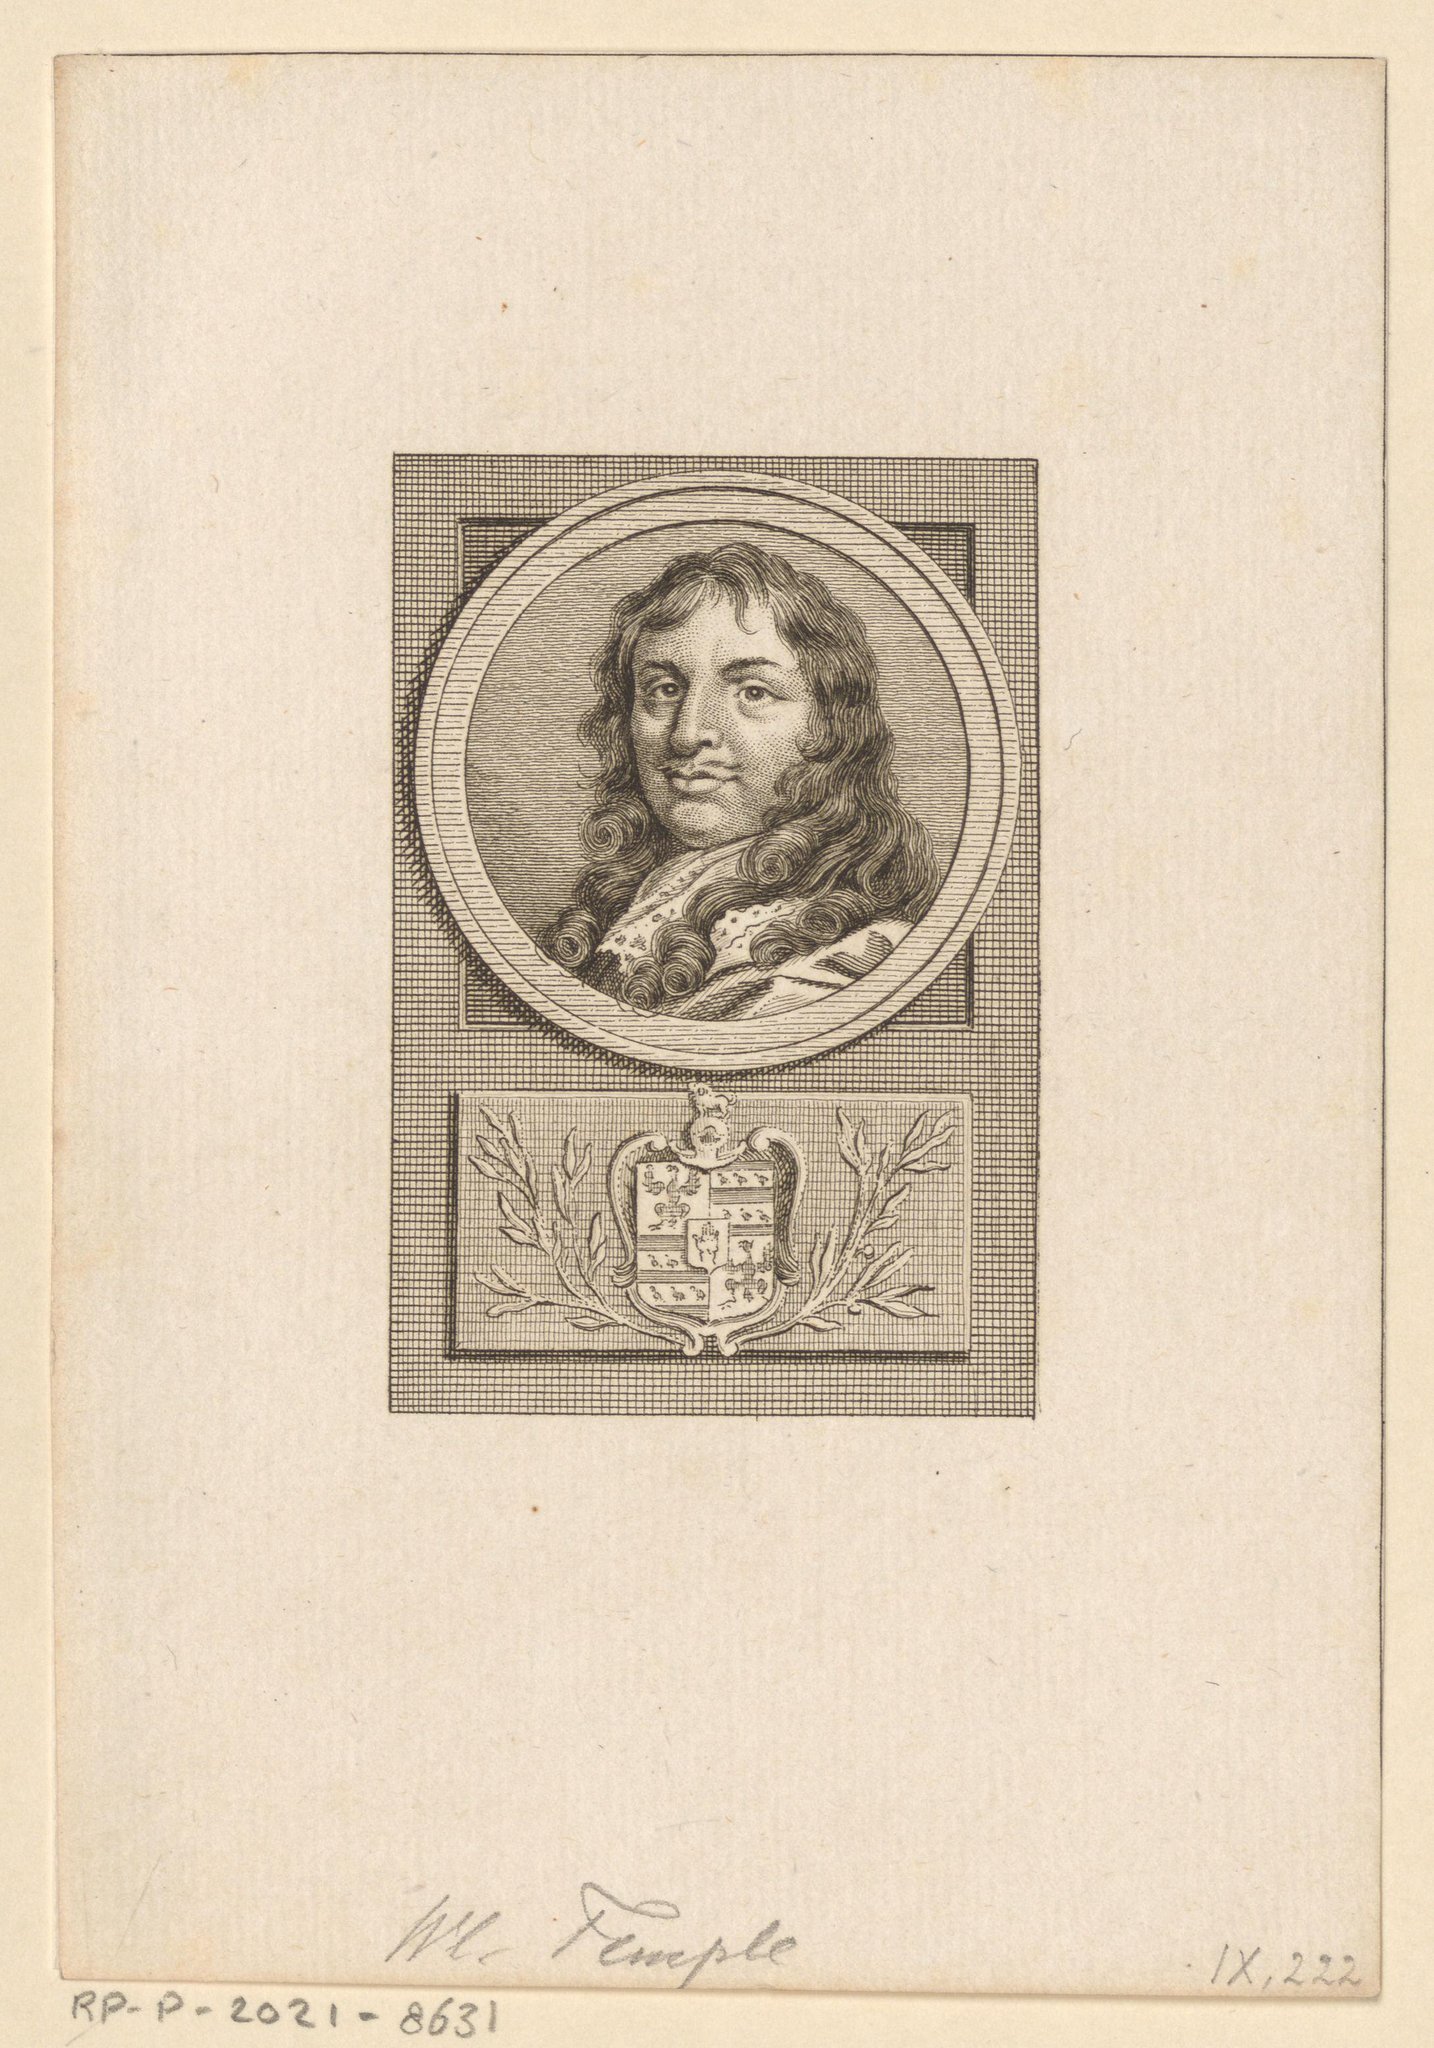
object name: print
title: Portret van William Temple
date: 1783-1795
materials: paper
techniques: engraving, etching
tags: historical persons, armorial bearing, heraldry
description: Latere staat van de prent gebruikt in: Fokke, Jan. Geschiedenissen der Vereenigde Nederlanden voor de vaderlandsche jeugd (...). Amsterdam: Johannes Allart, 1783-1795, dl. 9.